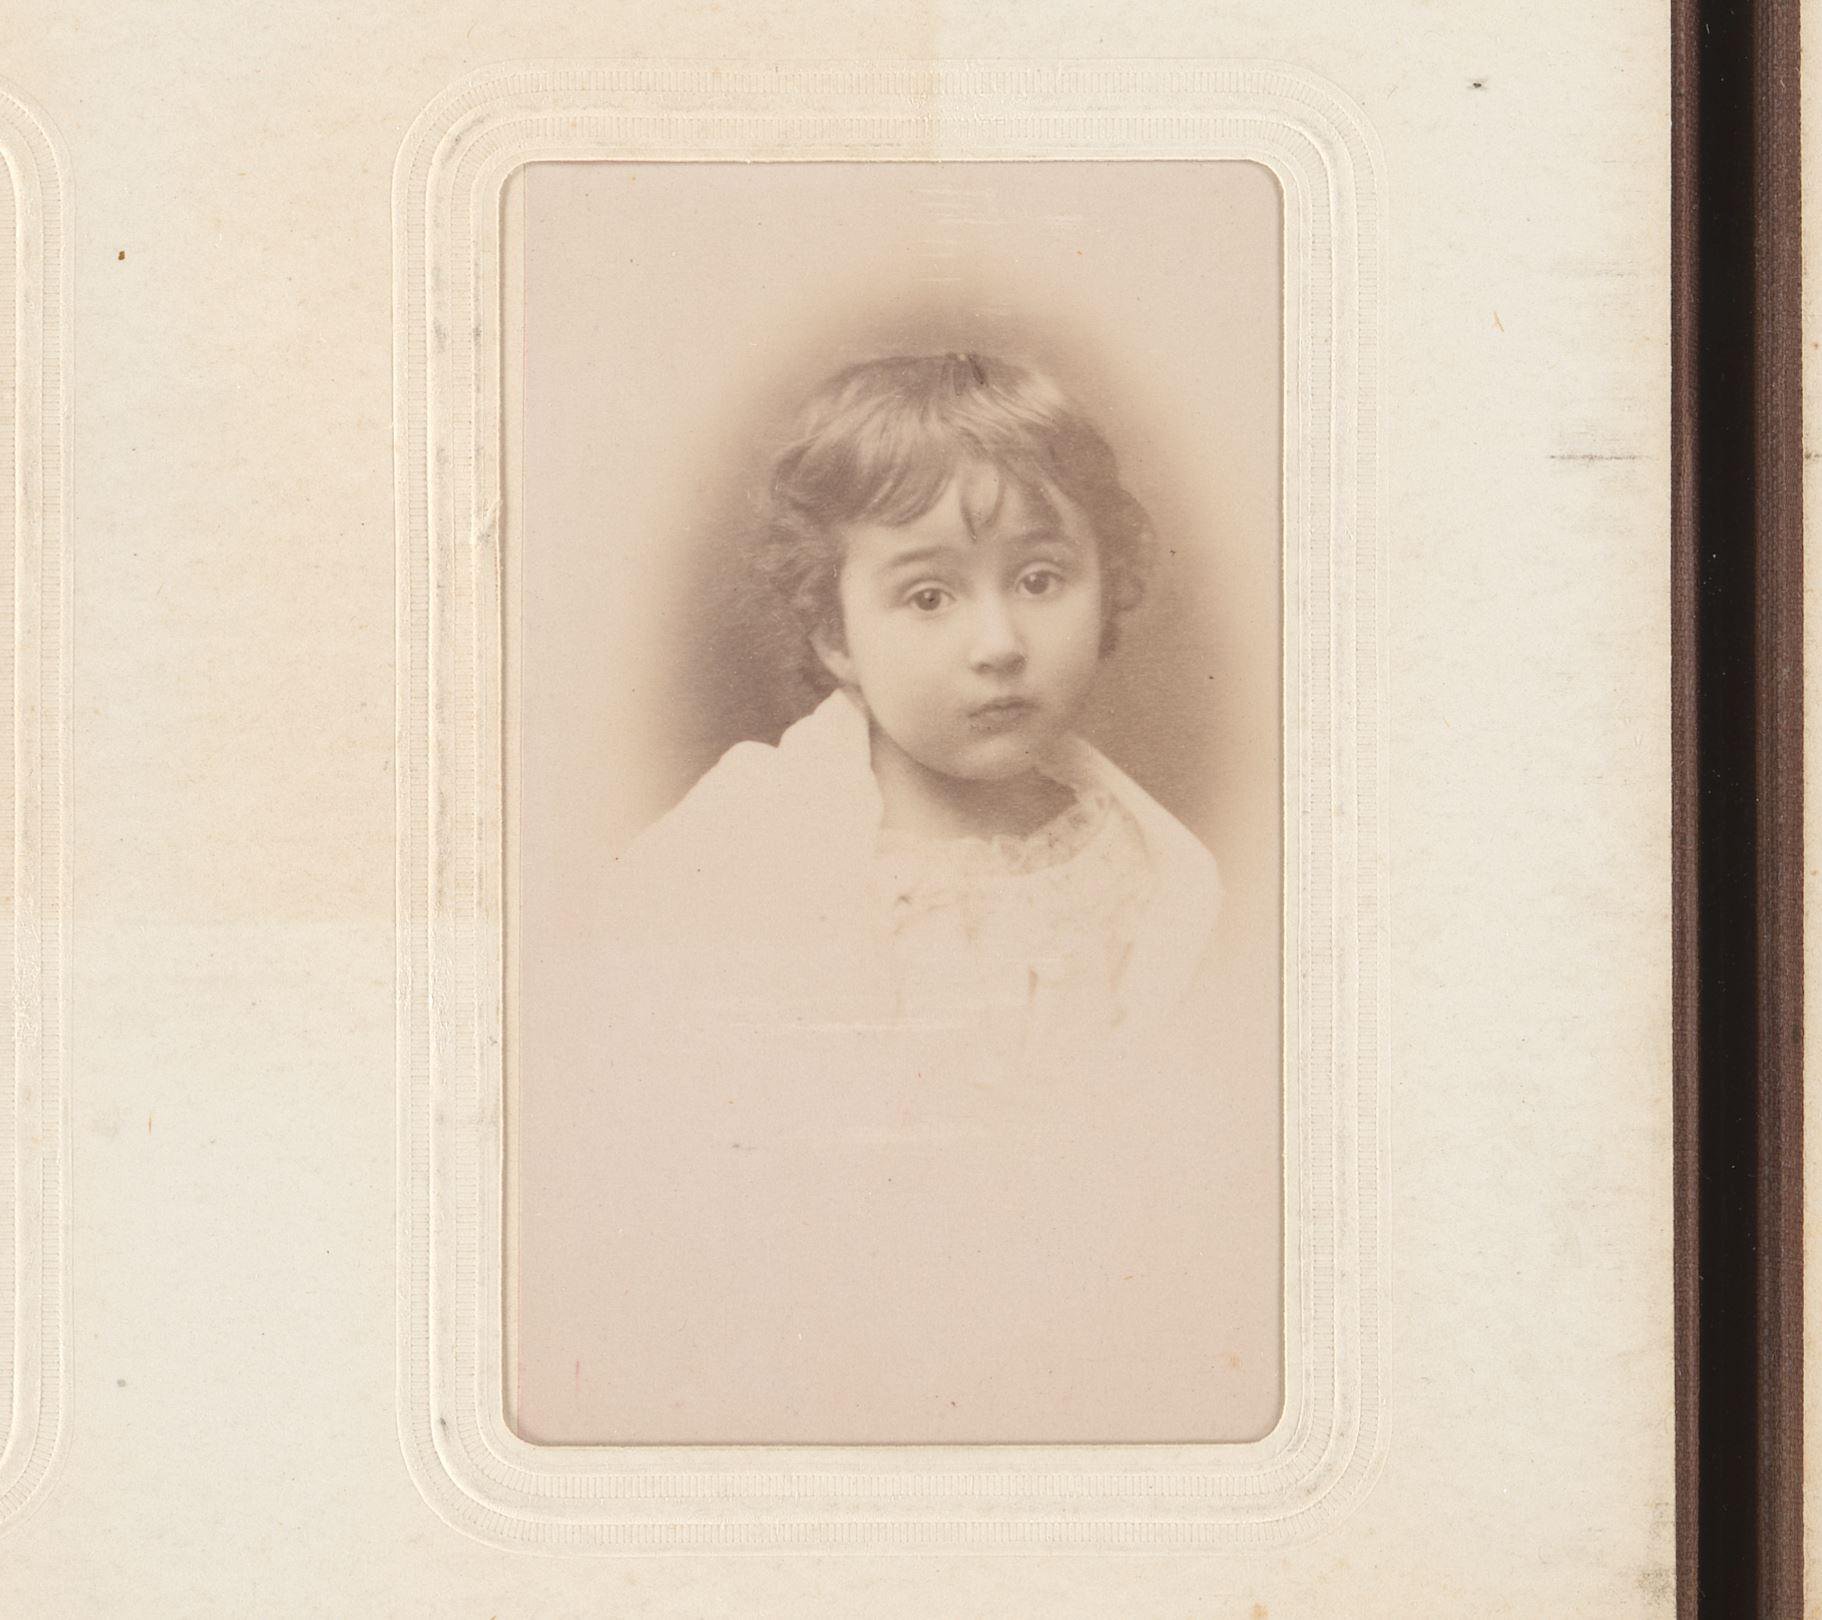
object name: photograph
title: Portret van een kind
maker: Anonymous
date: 1865-1900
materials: cardboard, paper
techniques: albumen print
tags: child, historical persons